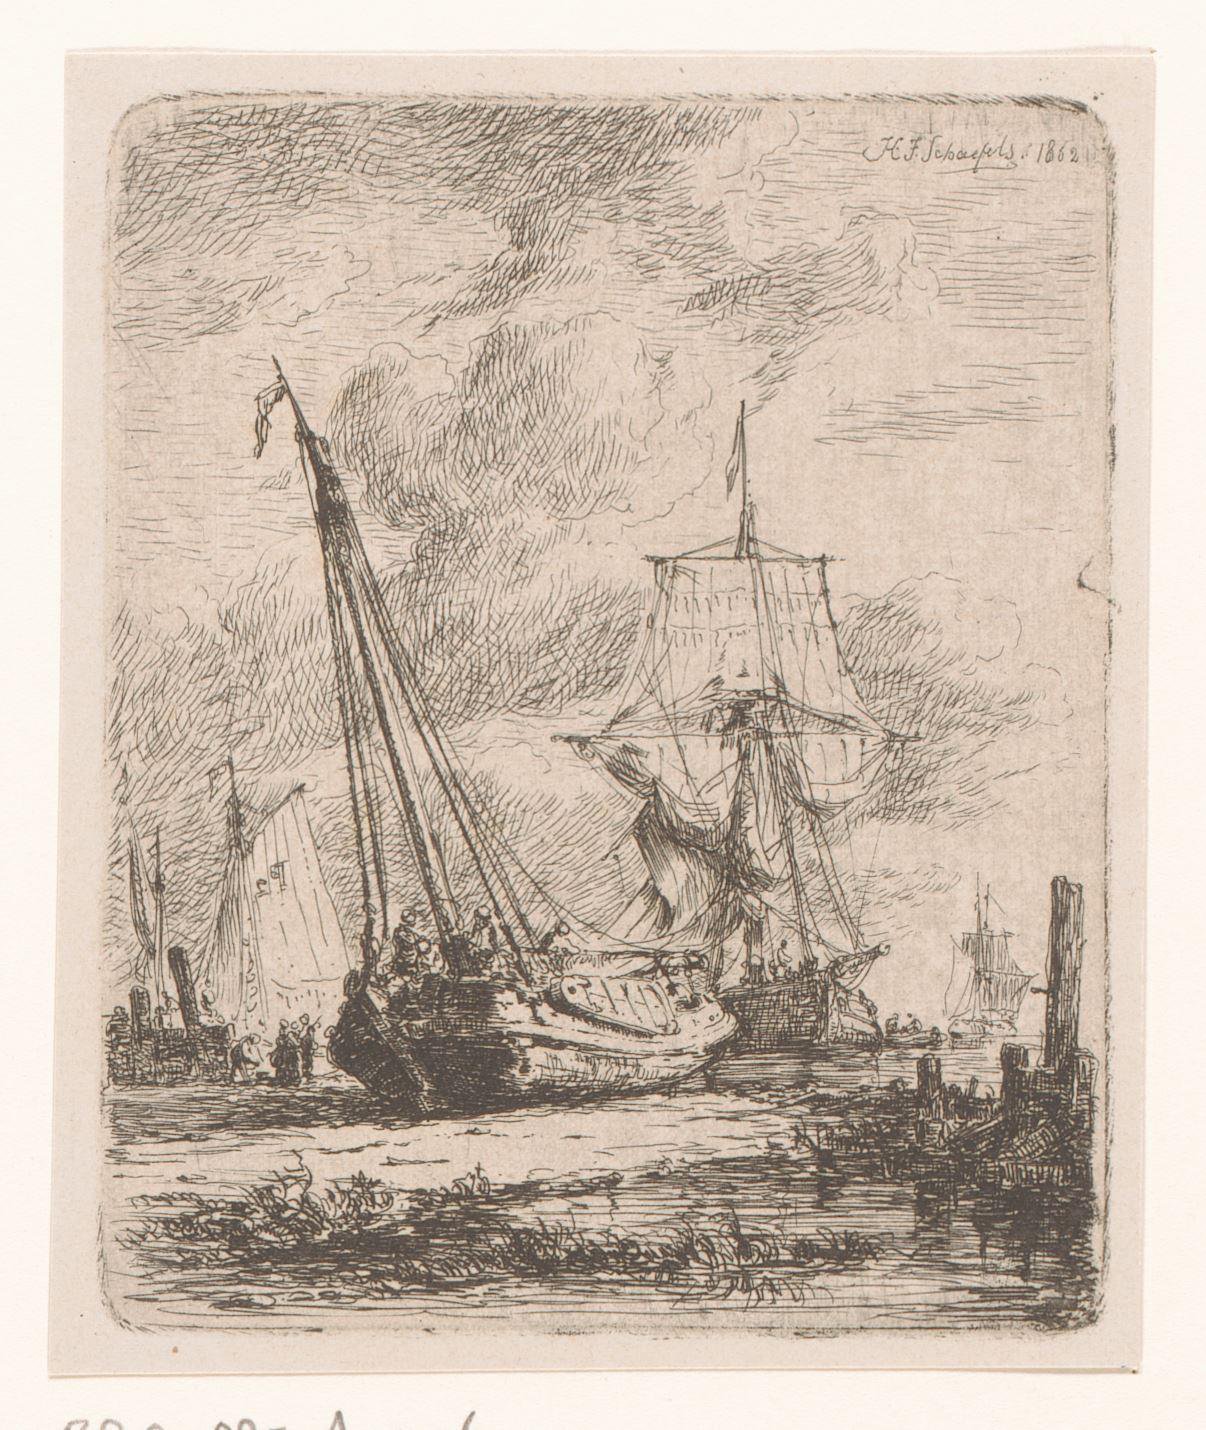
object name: print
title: Schepen op het droge en in het water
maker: henri françois schaefels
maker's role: print maker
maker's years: 1827-1904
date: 1862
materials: paper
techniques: etching, intaglio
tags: sailing-ship, sailing-boat, landscapes with waters, waterscapes, seascapes (in the temperate zone), ships, boats on land, beached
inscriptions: collector's mark: Lugt 2228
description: Latere staat verschenen in: Album du journal des beaux-arts, dix eaux-fortes inédites. Antwerpen: Typographie A. Fontaine, 1872.